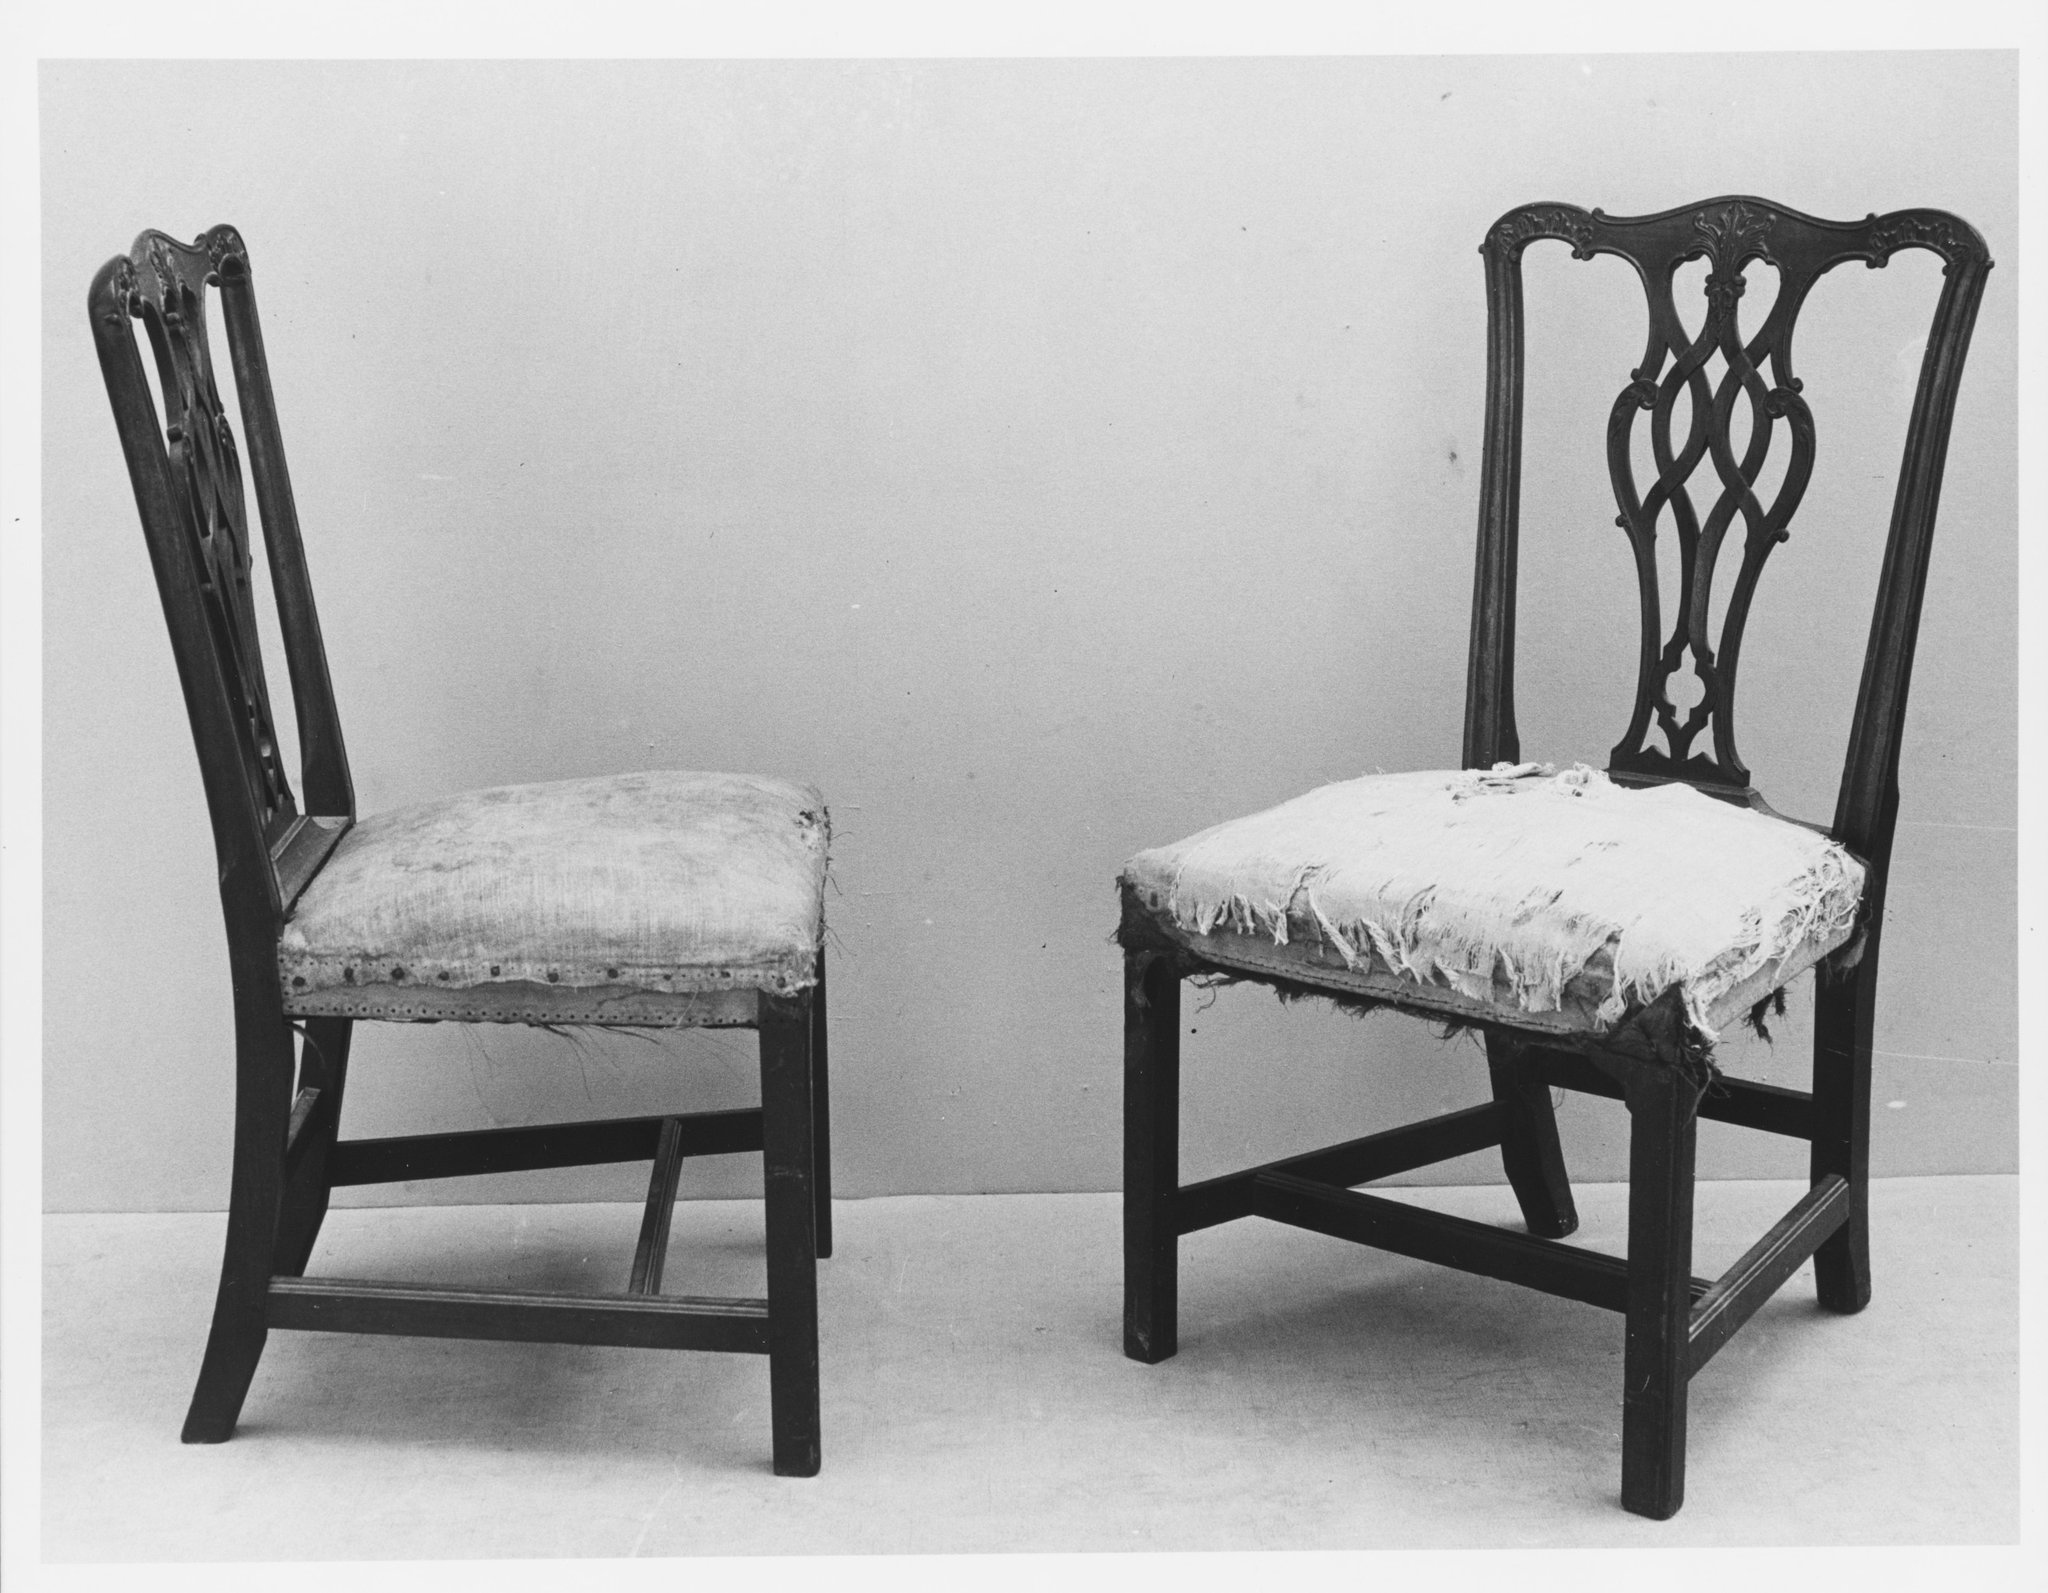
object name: side chair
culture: american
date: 1760-1790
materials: wood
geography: united states